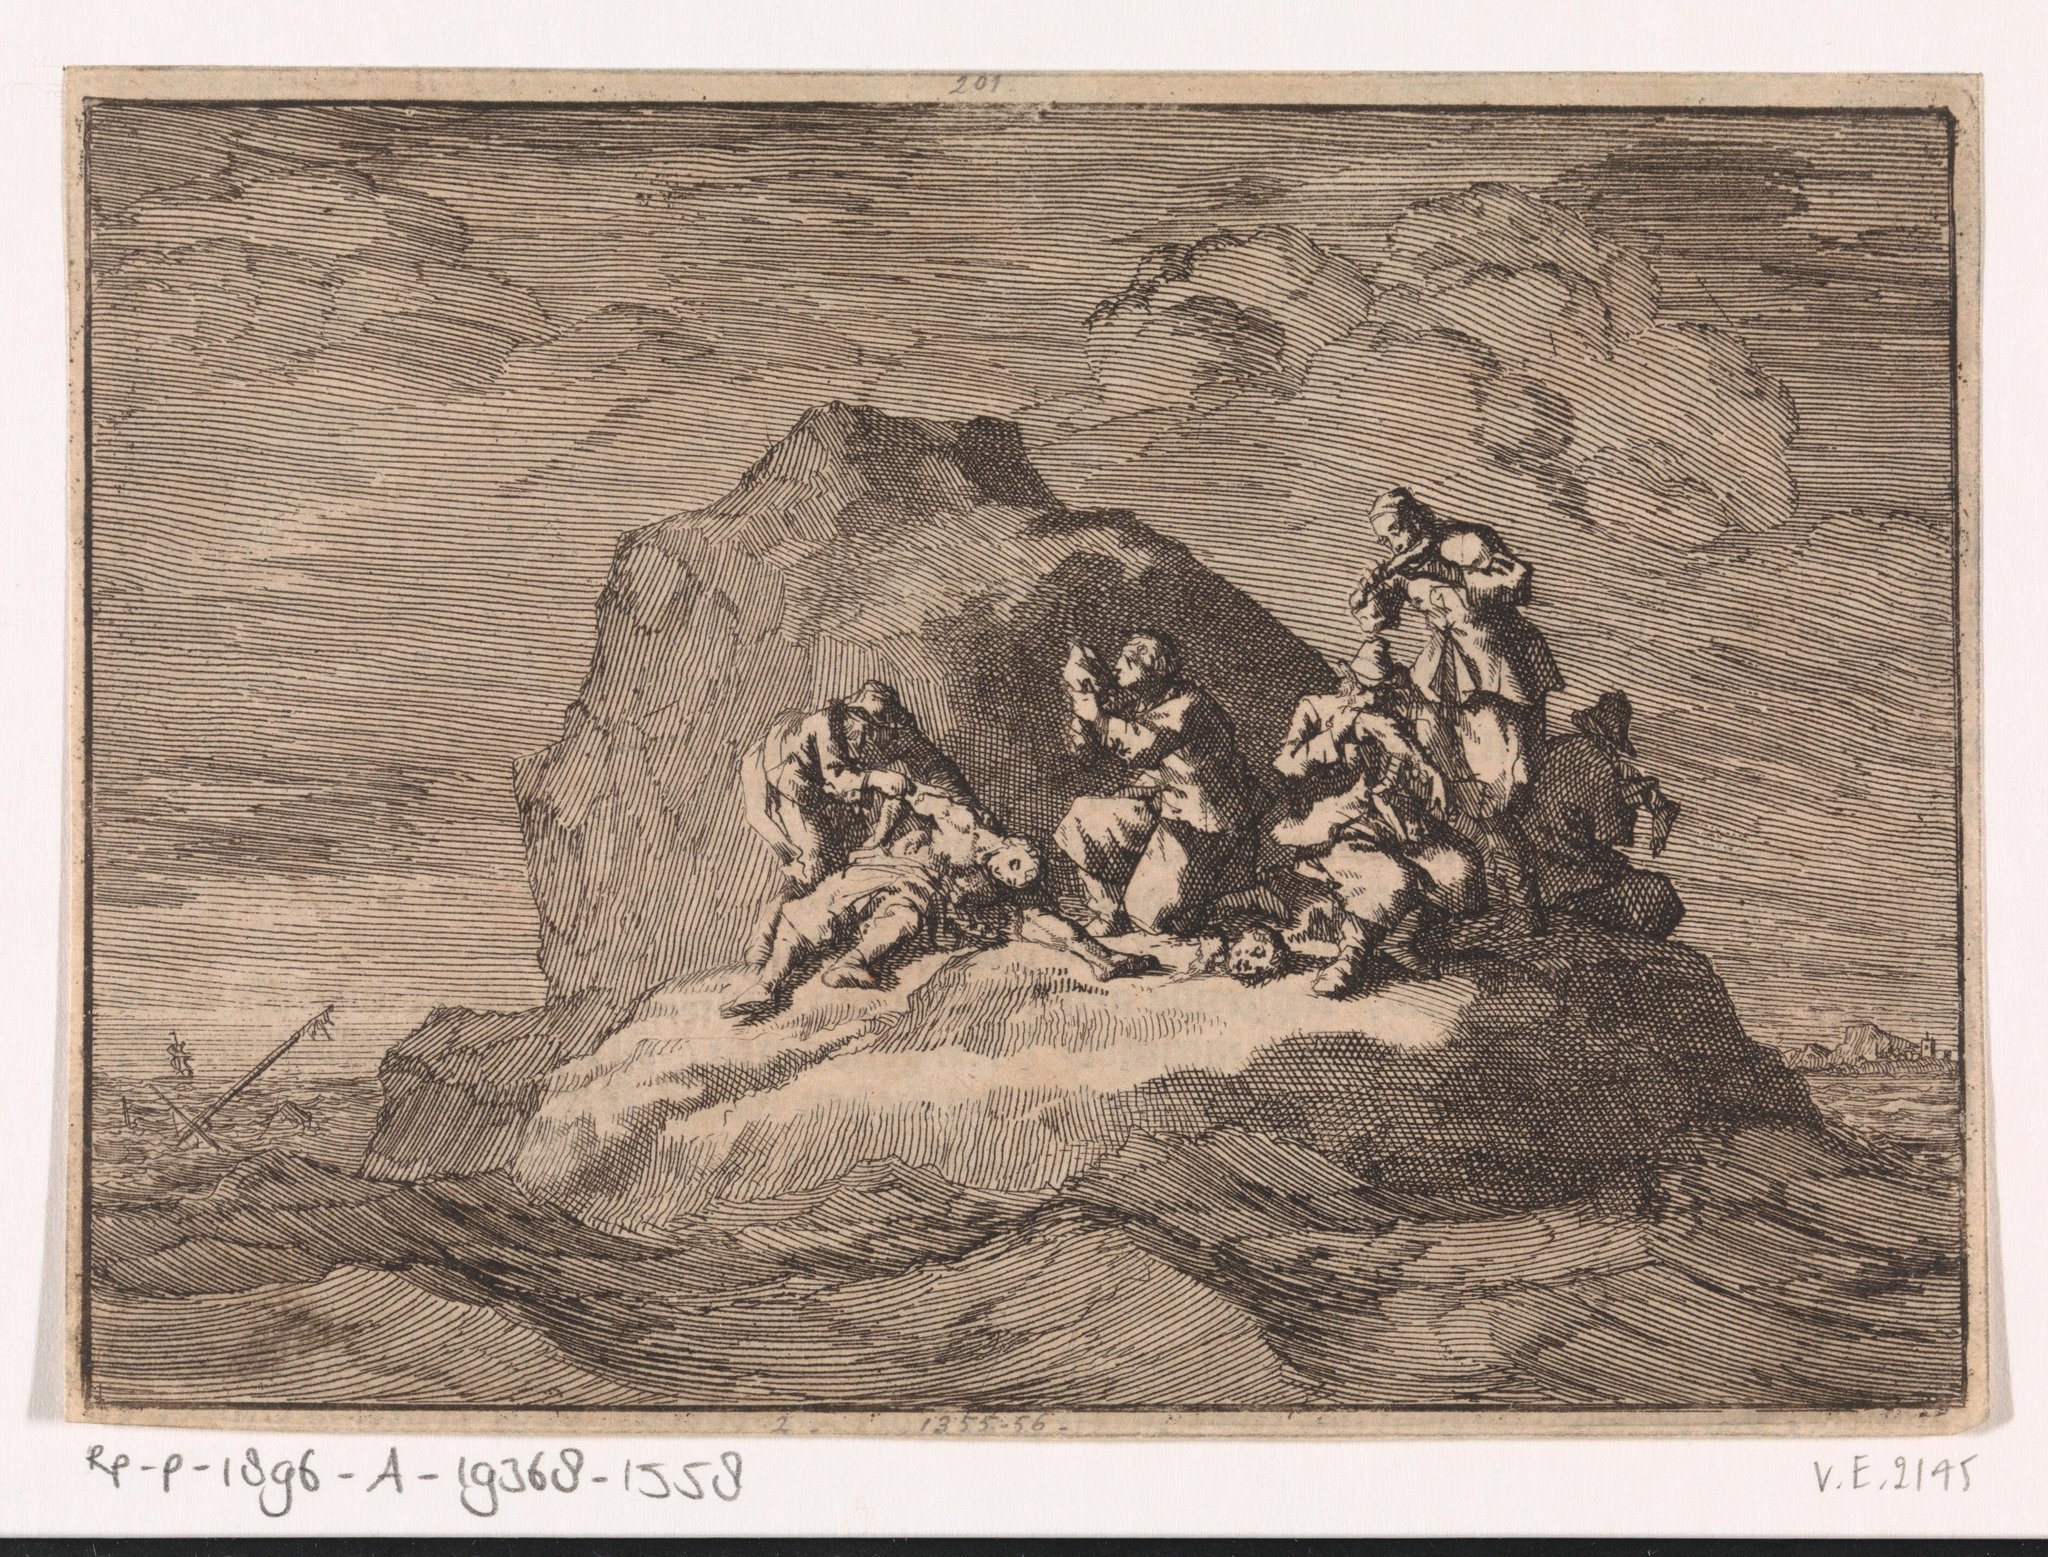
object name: print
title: Treurige toestand van zeven matrozen van het bij Halmstad verongelukte schip De Karseboom, 1678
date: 1698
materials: paper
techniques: etching, letterpress printing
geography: amsterdam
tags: reef ~ coast, drowning, shipwrecked person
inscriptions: collector's mark: Lugt 2228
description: Illustratie uit: Gottfried, Johann Ludwig. Historische kronyck; vervattende een (...) beschrijvingh der aldergedenckwaerdigste geschiedenissen des weerelds, van den aenvangh der scheppingh tot (...) 1576 (2 delen). Leiden: Pieter van der Aa, 1698, dl. II, p. 1355.